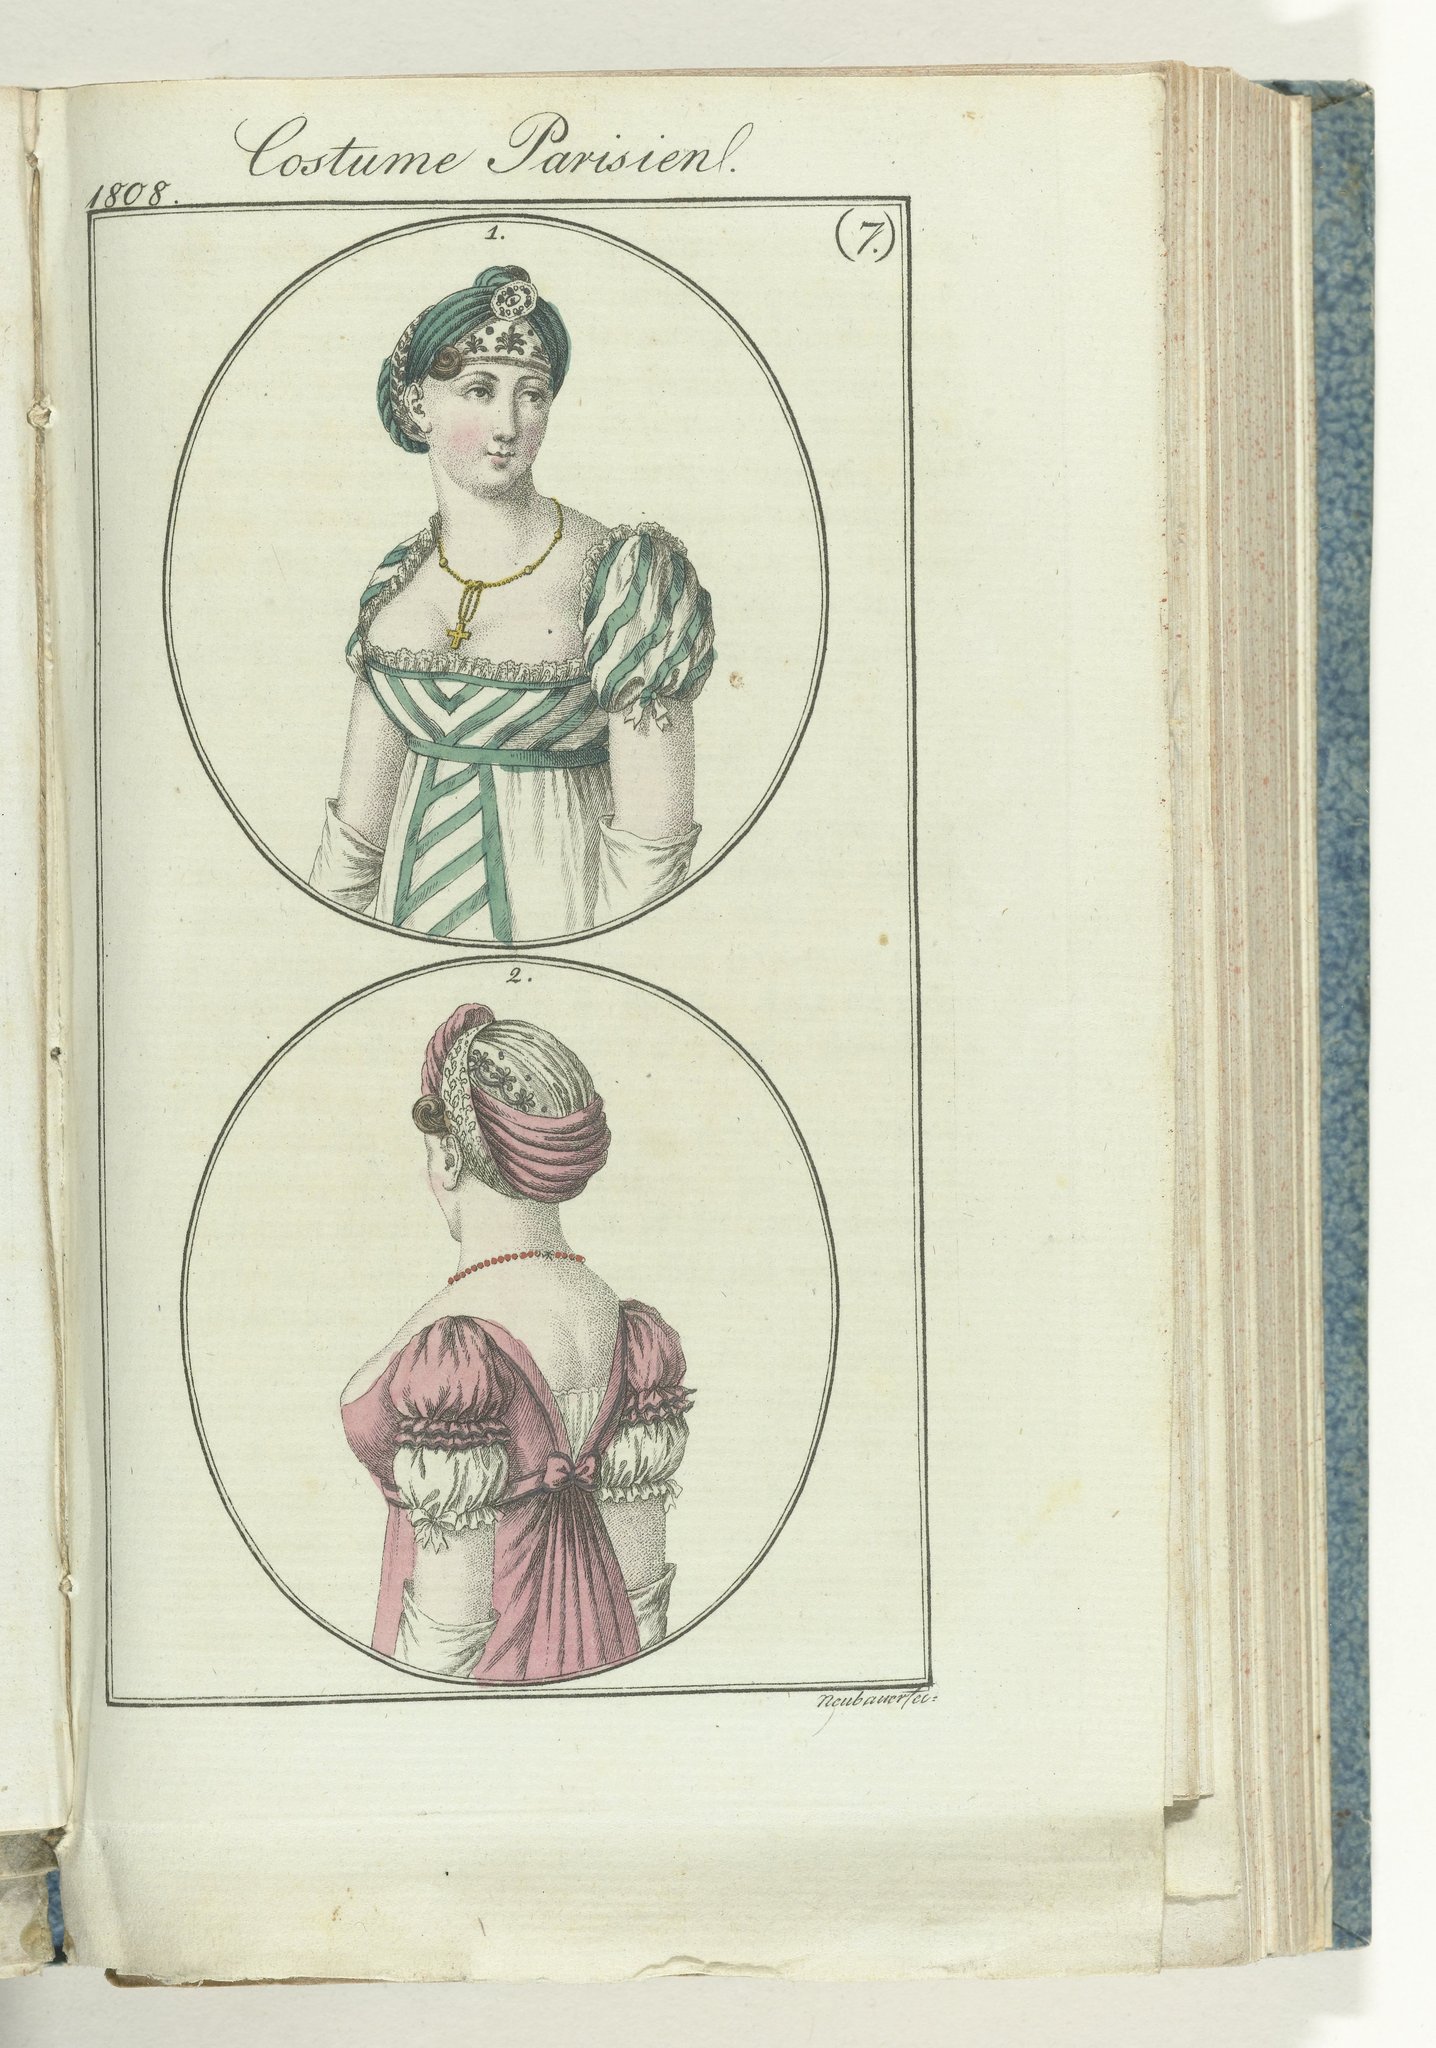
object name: magazine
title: Journal des Dames et des Modes, editie Frankfurt 15 Février 1808, Costume Parisien (7)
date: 1808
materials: paper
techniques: engraving, hand coloring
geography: frankfurt am main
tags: head-gear: turban (+ women's clothes), gloves, mittens (long gloves) (+ women's clothes), styles of hairdress - aa - ~ women, fashion plates, dress, gown (+ women's clothes), sleeves (+ women's clothes), necklace (+ women's clothes)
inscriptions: title: ‘Costume Parisien.’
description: Twee vrouwenfiguurtjes, ten halven lijve met tulbandachtige hoofddeksels, in ovalen. De begeleidende tekst (p. 181) vermeldt: Coiffure gedeeltelijk met fluweel, gedeeltelijk met gaas van gouddraad. Collier. Witte japon garnie en rubans. Fig. 2: Hetzelfde kapsel maar nu met fluweel en geborduurde mousseline. Collier van koraal. Japon van roze crêpe, garnie avec des filets d'argent. Manches à l'enfant. De prent maakt deel uit van het modetijdschrift Journal des Dames et des Modes, uitgegeven in Frankfurt als kopie van de Franse editie van Pierre de la Mésangère, (1798-1848).